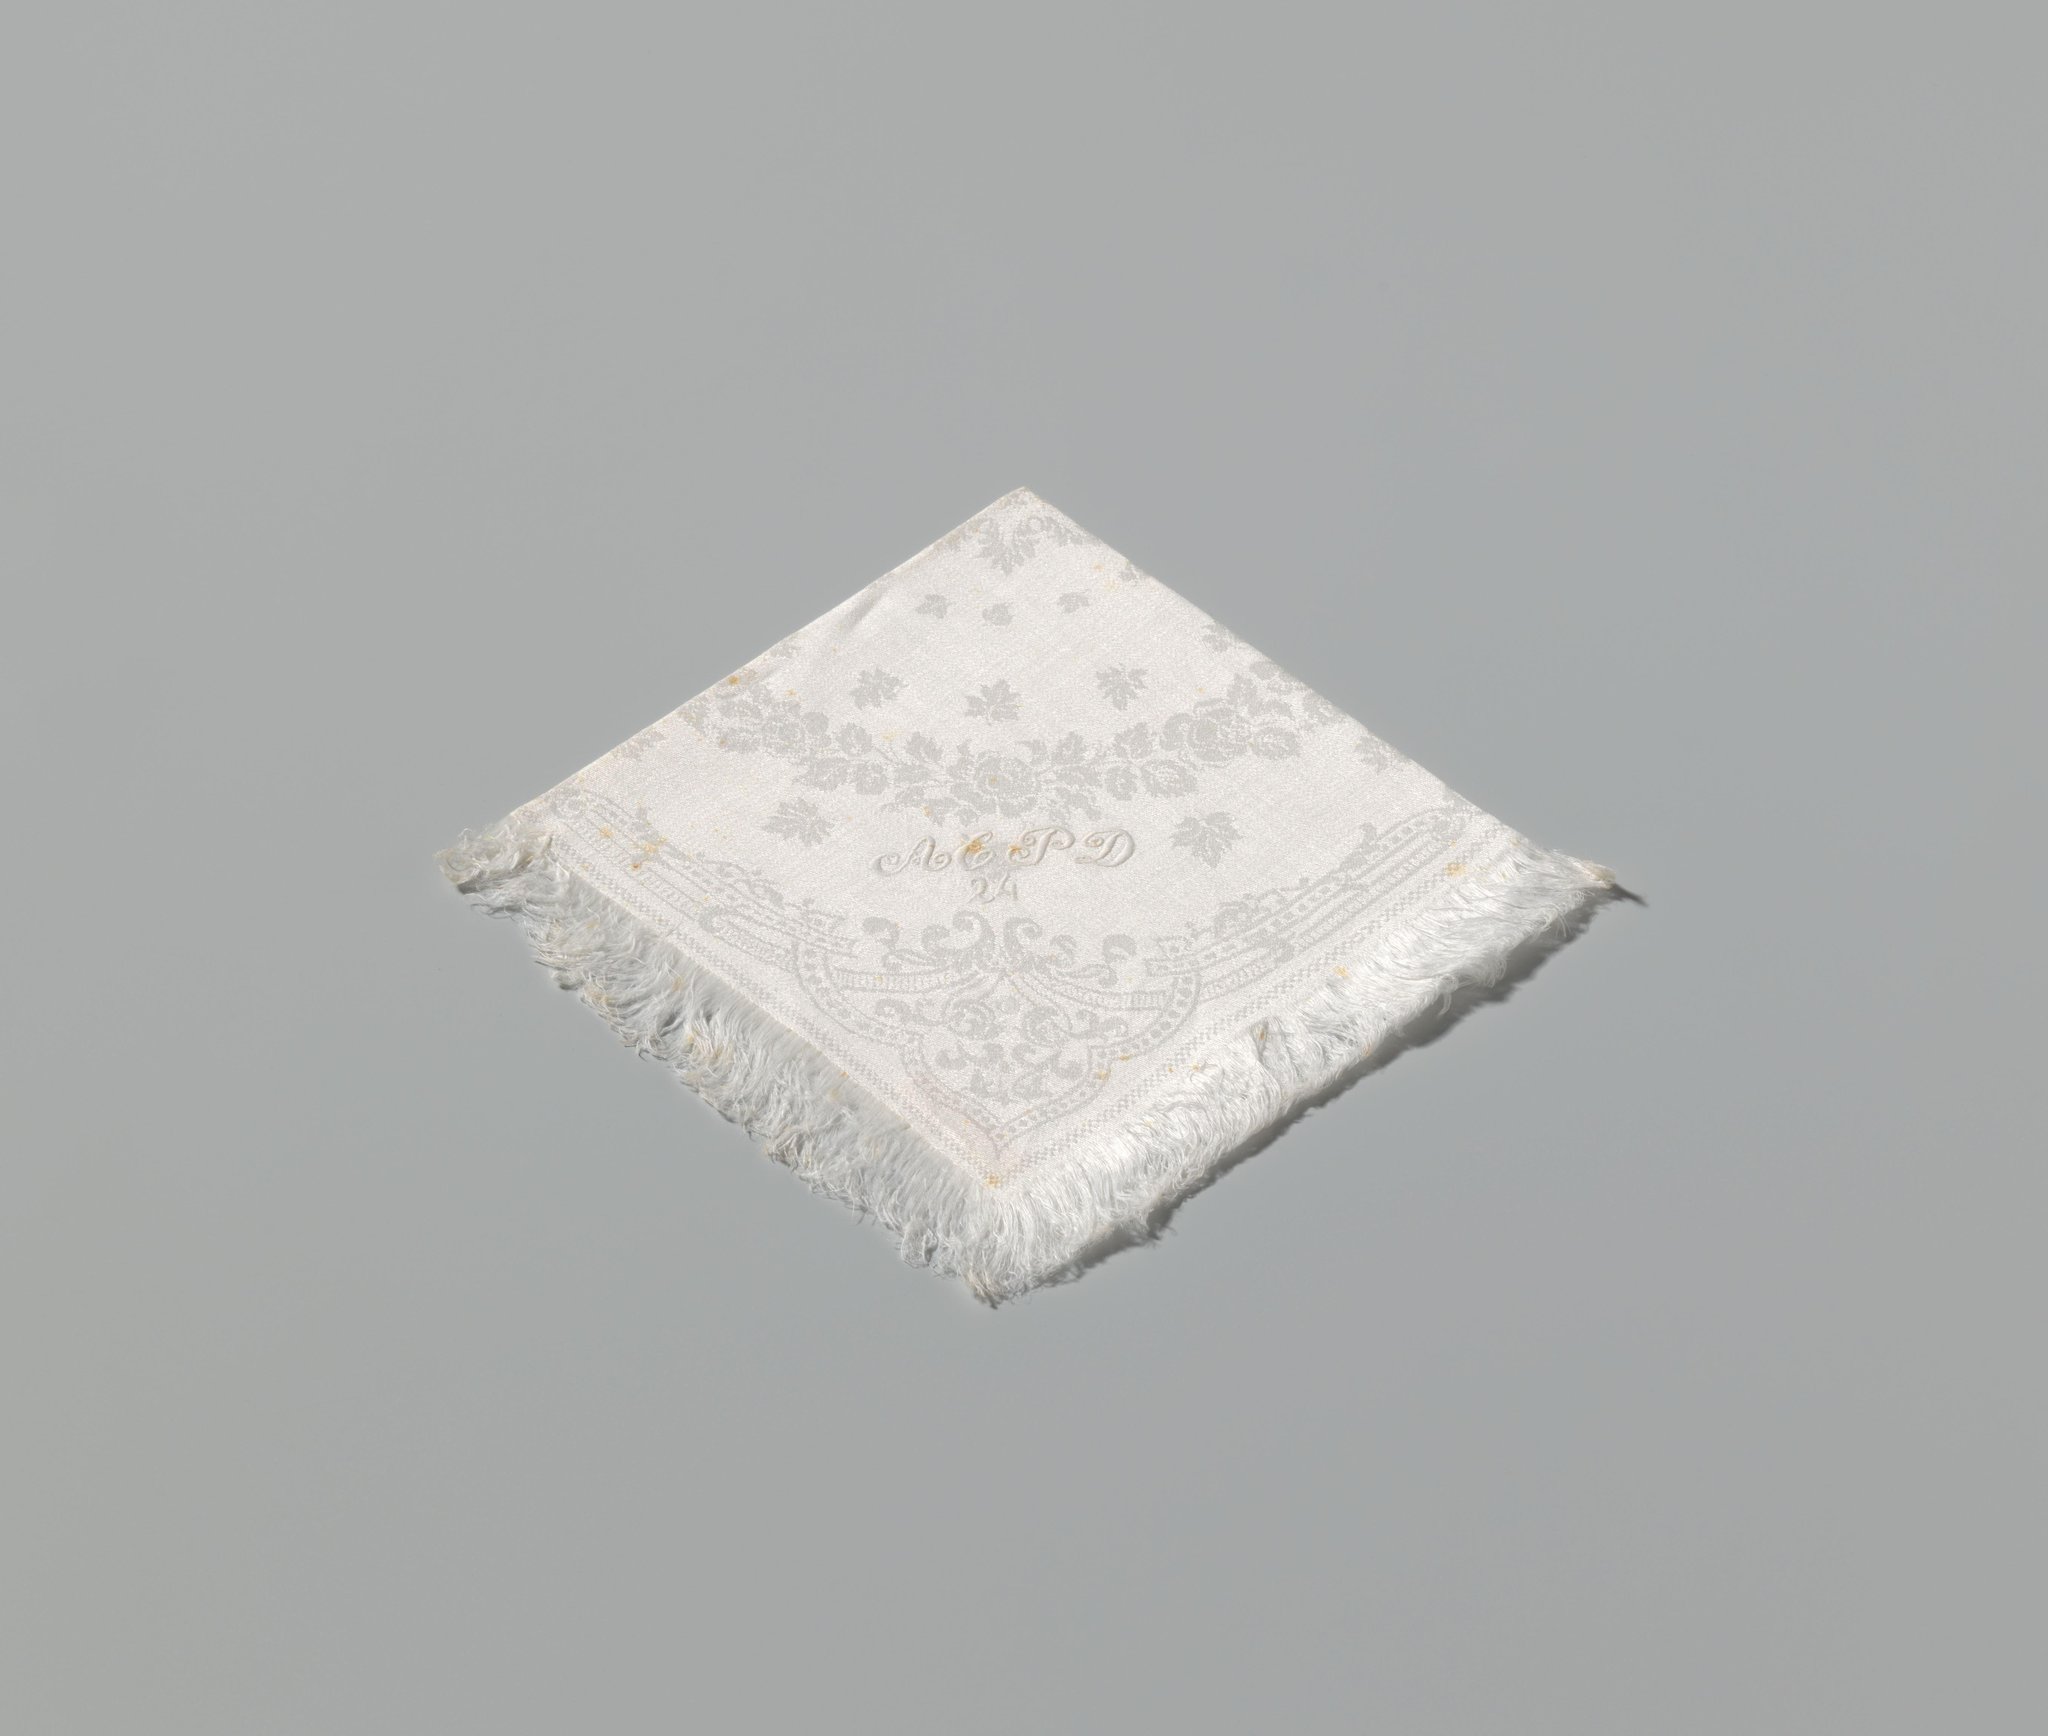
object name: vingerdoek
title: Vingerdoek van linnendamast met een bloempatroon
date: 1875-1900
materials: linen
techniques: damask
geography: germany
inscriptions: monogram: ‘AEPD 24’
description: Vingerdoek van linnendamast met op het veld een bloemenkrans waarbinnen een rozet van bladeren en waaromheen gestrooide bladeren. Langs de rand een bloempatroon. De vingerdoek heeft franje langs de rand en in wit geborduurde letters AEPD24. De vingerdoek hoort bij negen vingerdoeken (BK-1979-269-A t/m BK-1979-269-J).